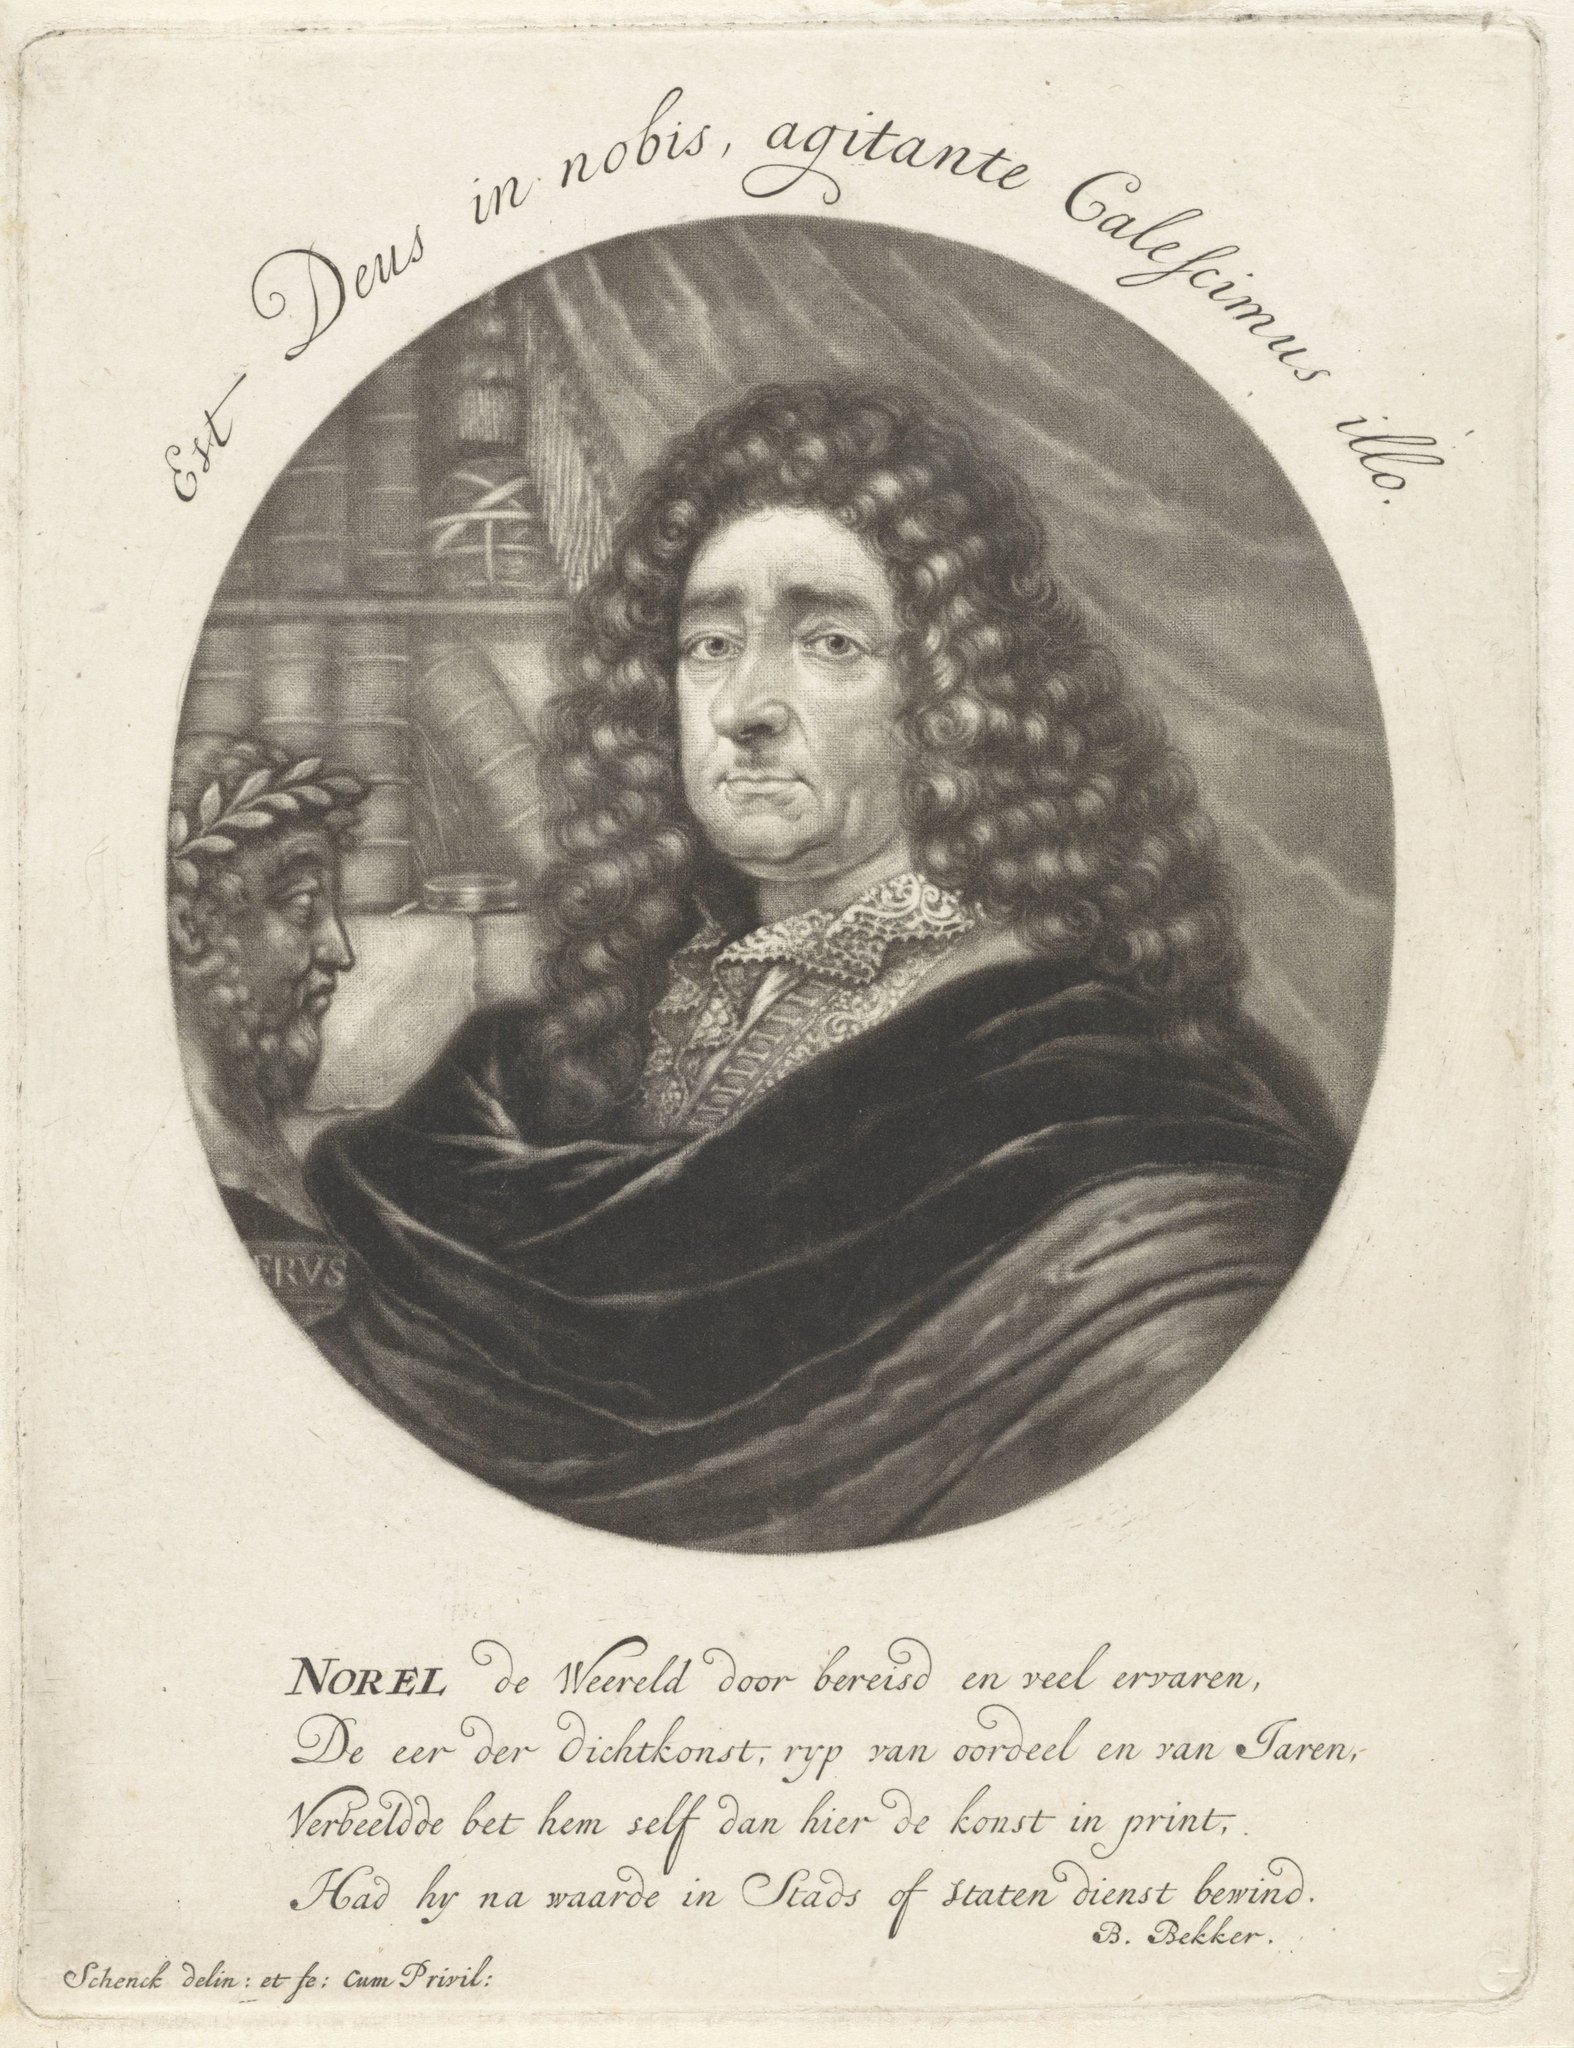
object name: print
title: Portret van de dichter Jan Norel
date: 1700-1713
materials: paper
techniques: engraving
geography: amsterdam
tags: jan norel, portrait of a writer, book, wig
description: De dichter Jan Norel met allongepruik. Naast hem een buste en op de achtergrond een boekenkast.